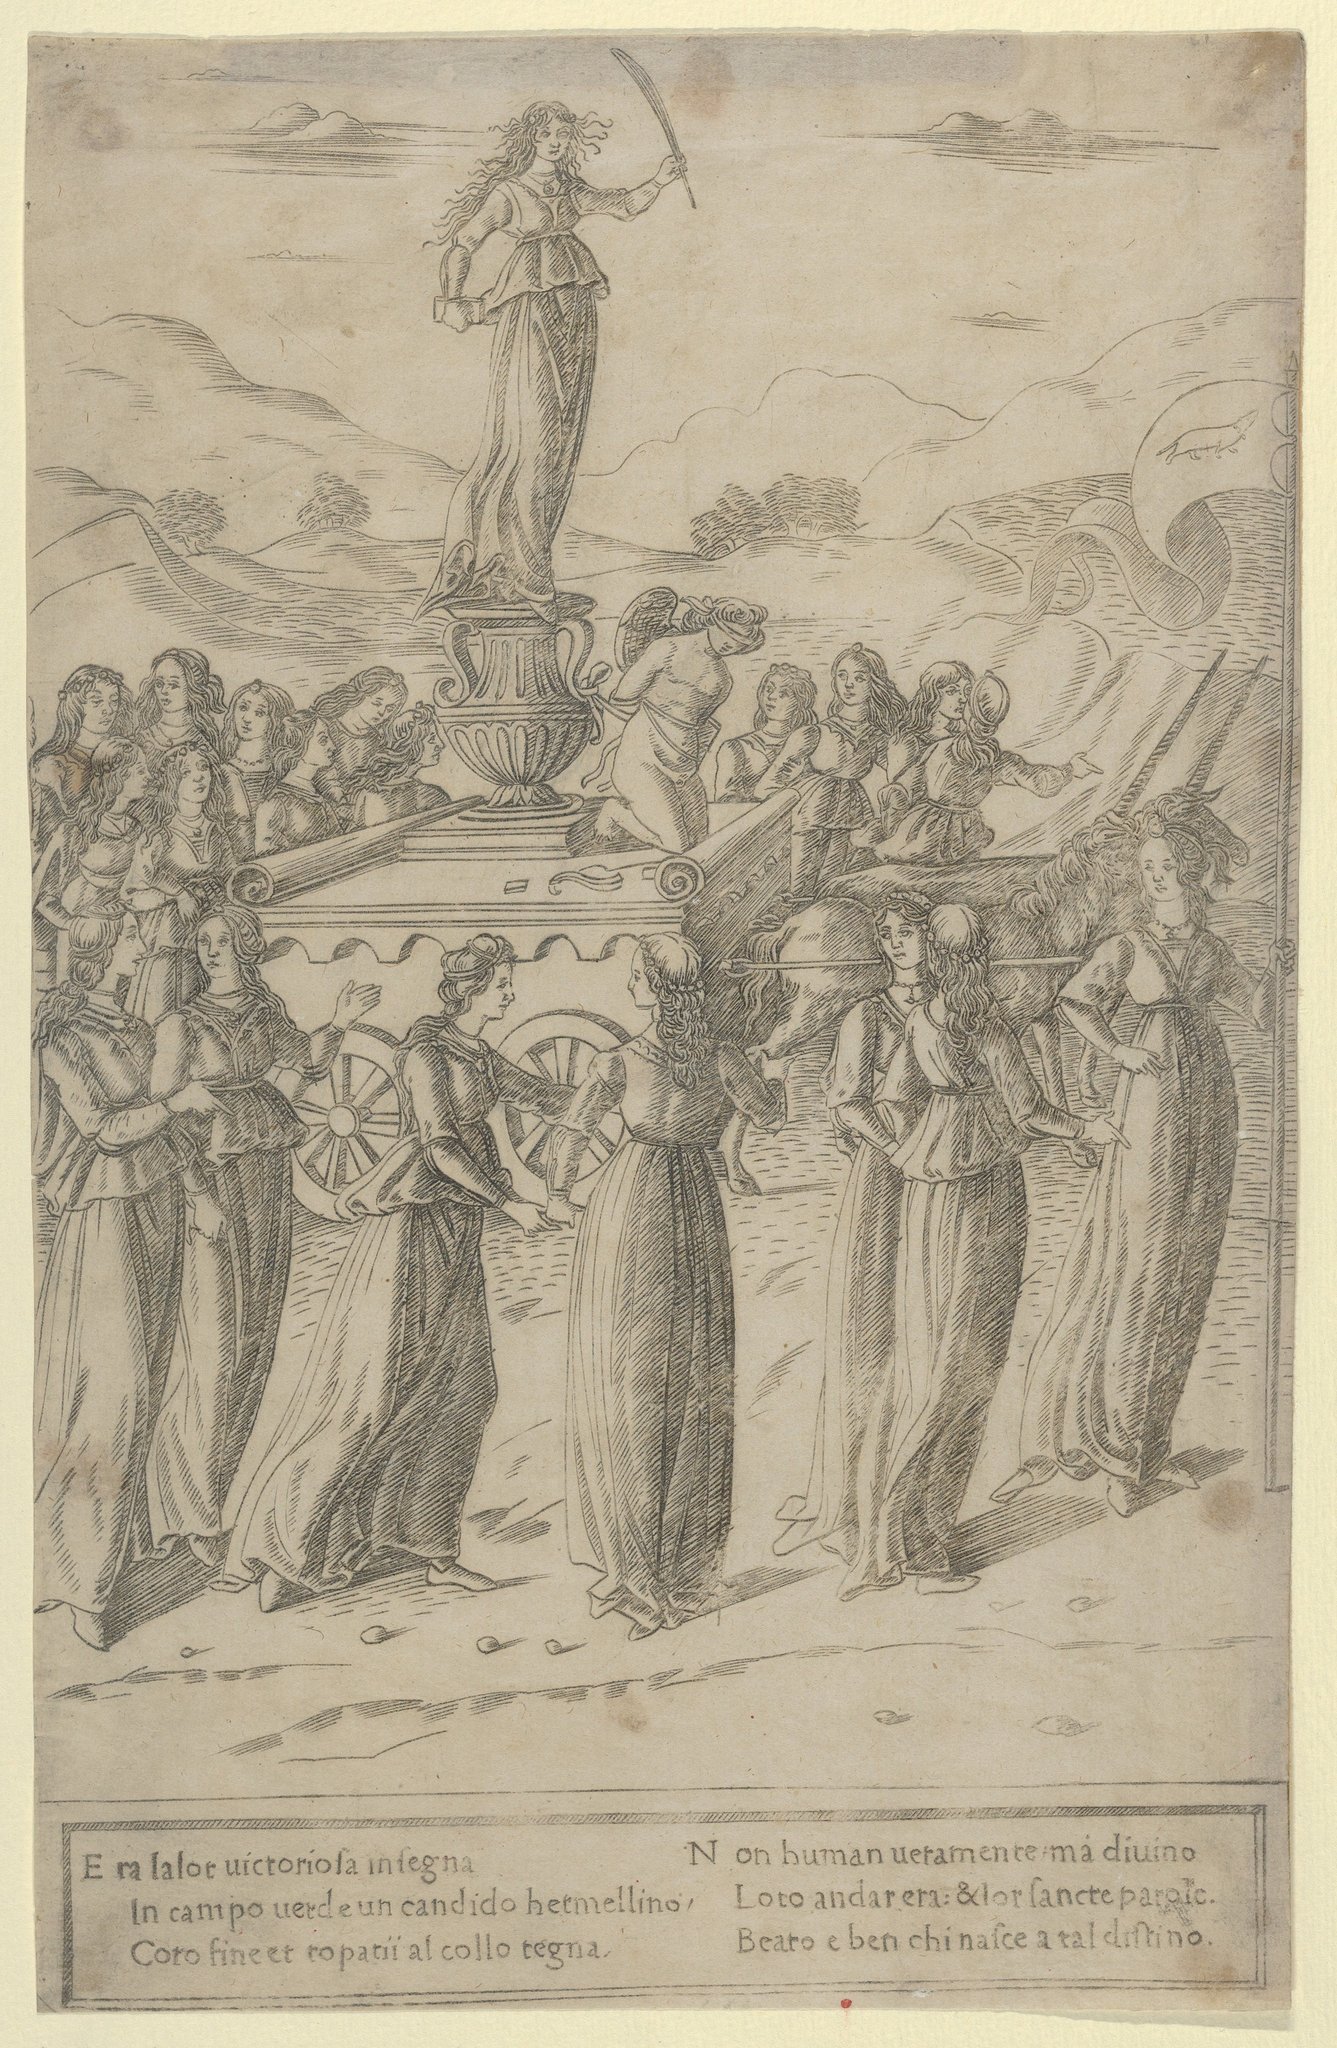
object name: print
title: The Triumph of Chastity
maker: francesco rosselli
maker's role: artist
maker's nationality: italian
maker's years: 1448-1527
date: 1480-1490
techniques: engraving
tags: women,cupid,chariots